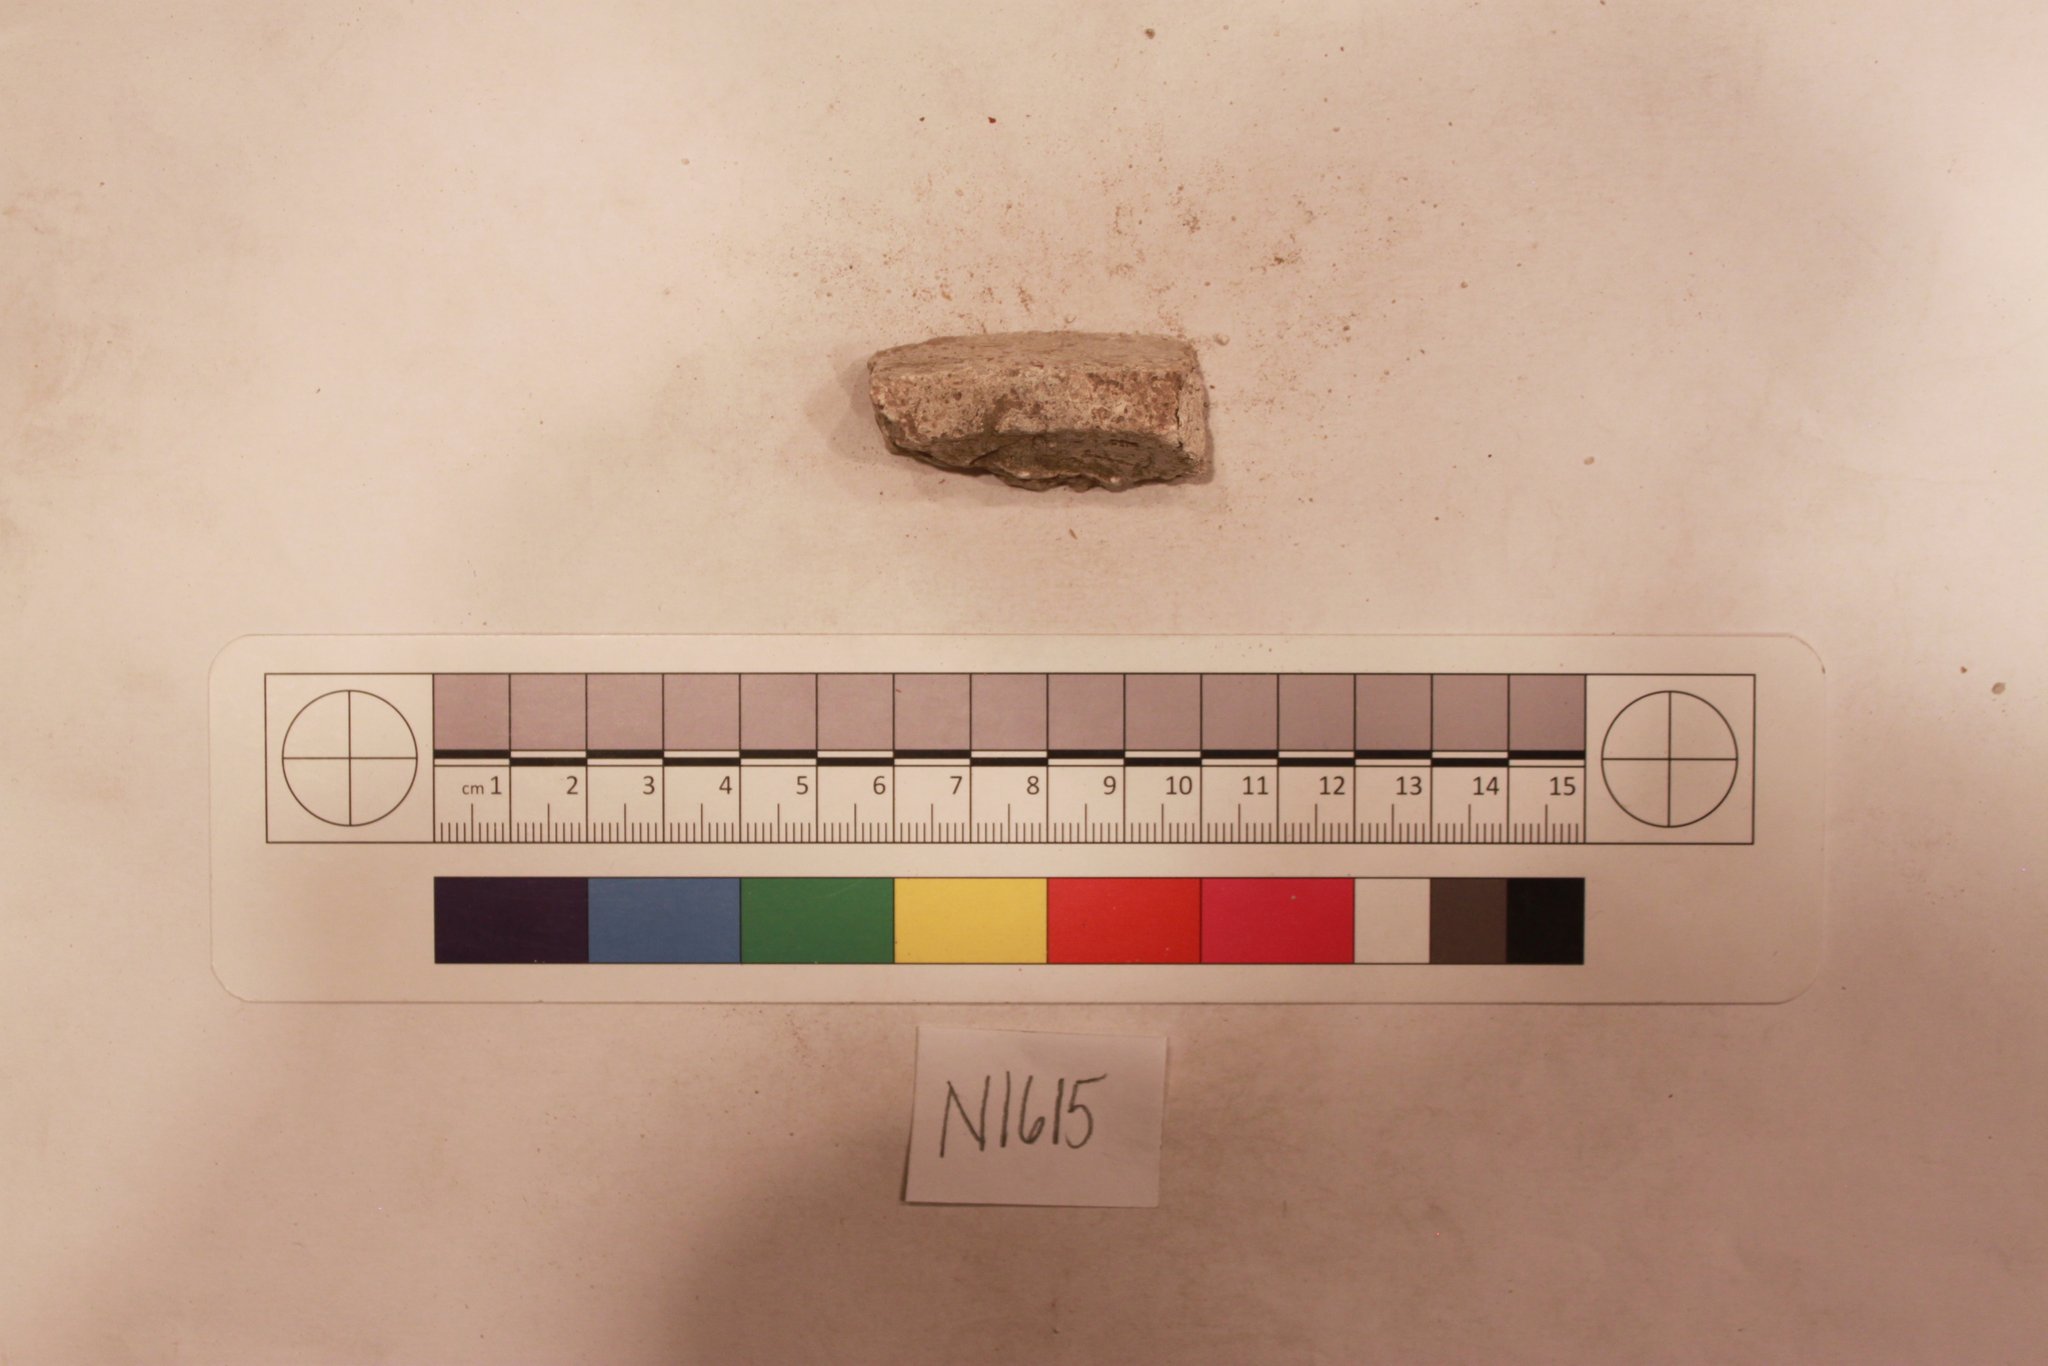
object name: fragment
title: Stucco Fragment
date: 701-1200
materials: plaster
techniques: carving, painting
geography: iran